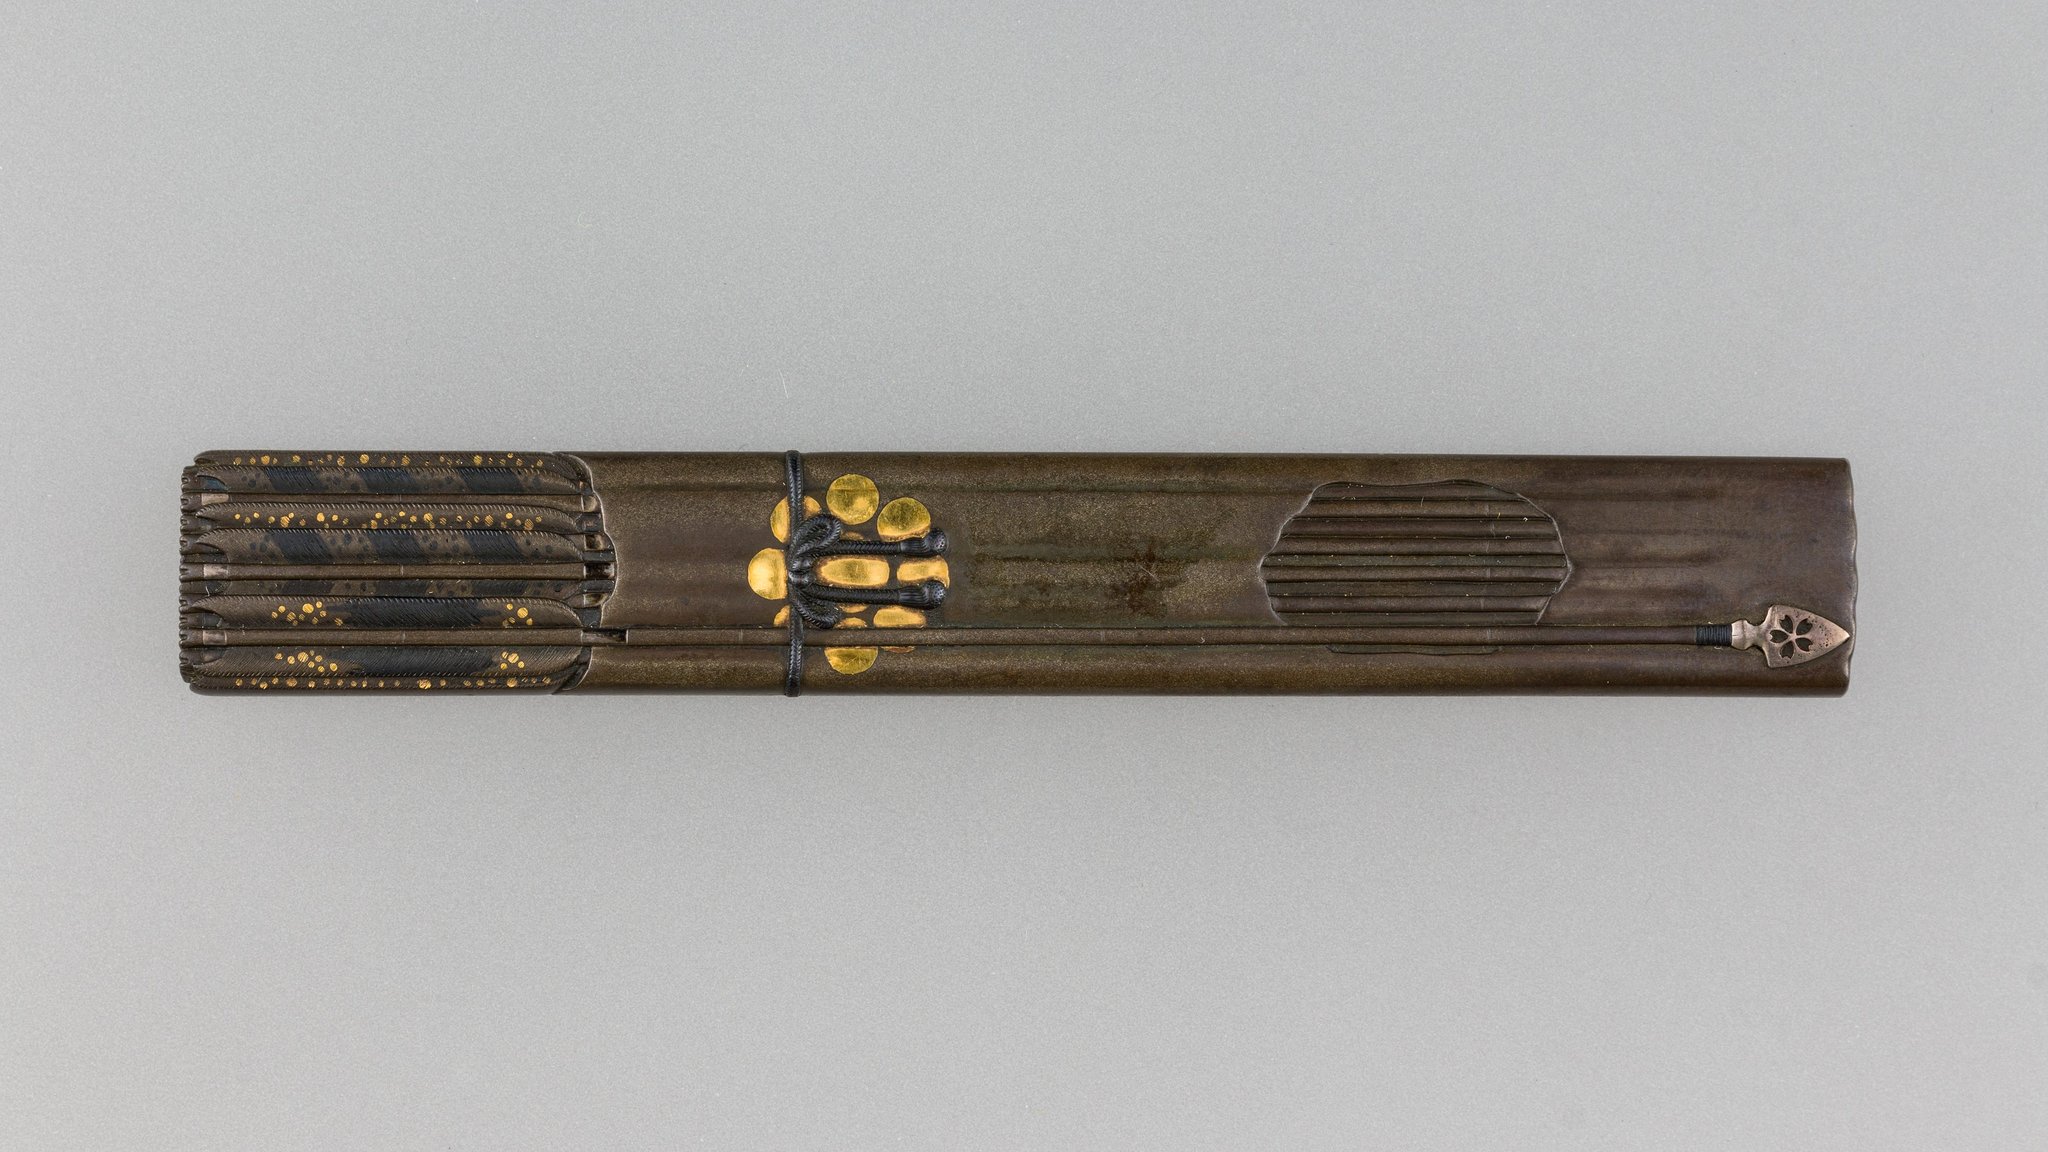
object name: knife handle kozuka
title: Knife Handle (Kozuka)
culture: japanese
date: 1701-1800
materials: gold alloy, silver alloy, gold, silver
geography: japan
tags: arrows